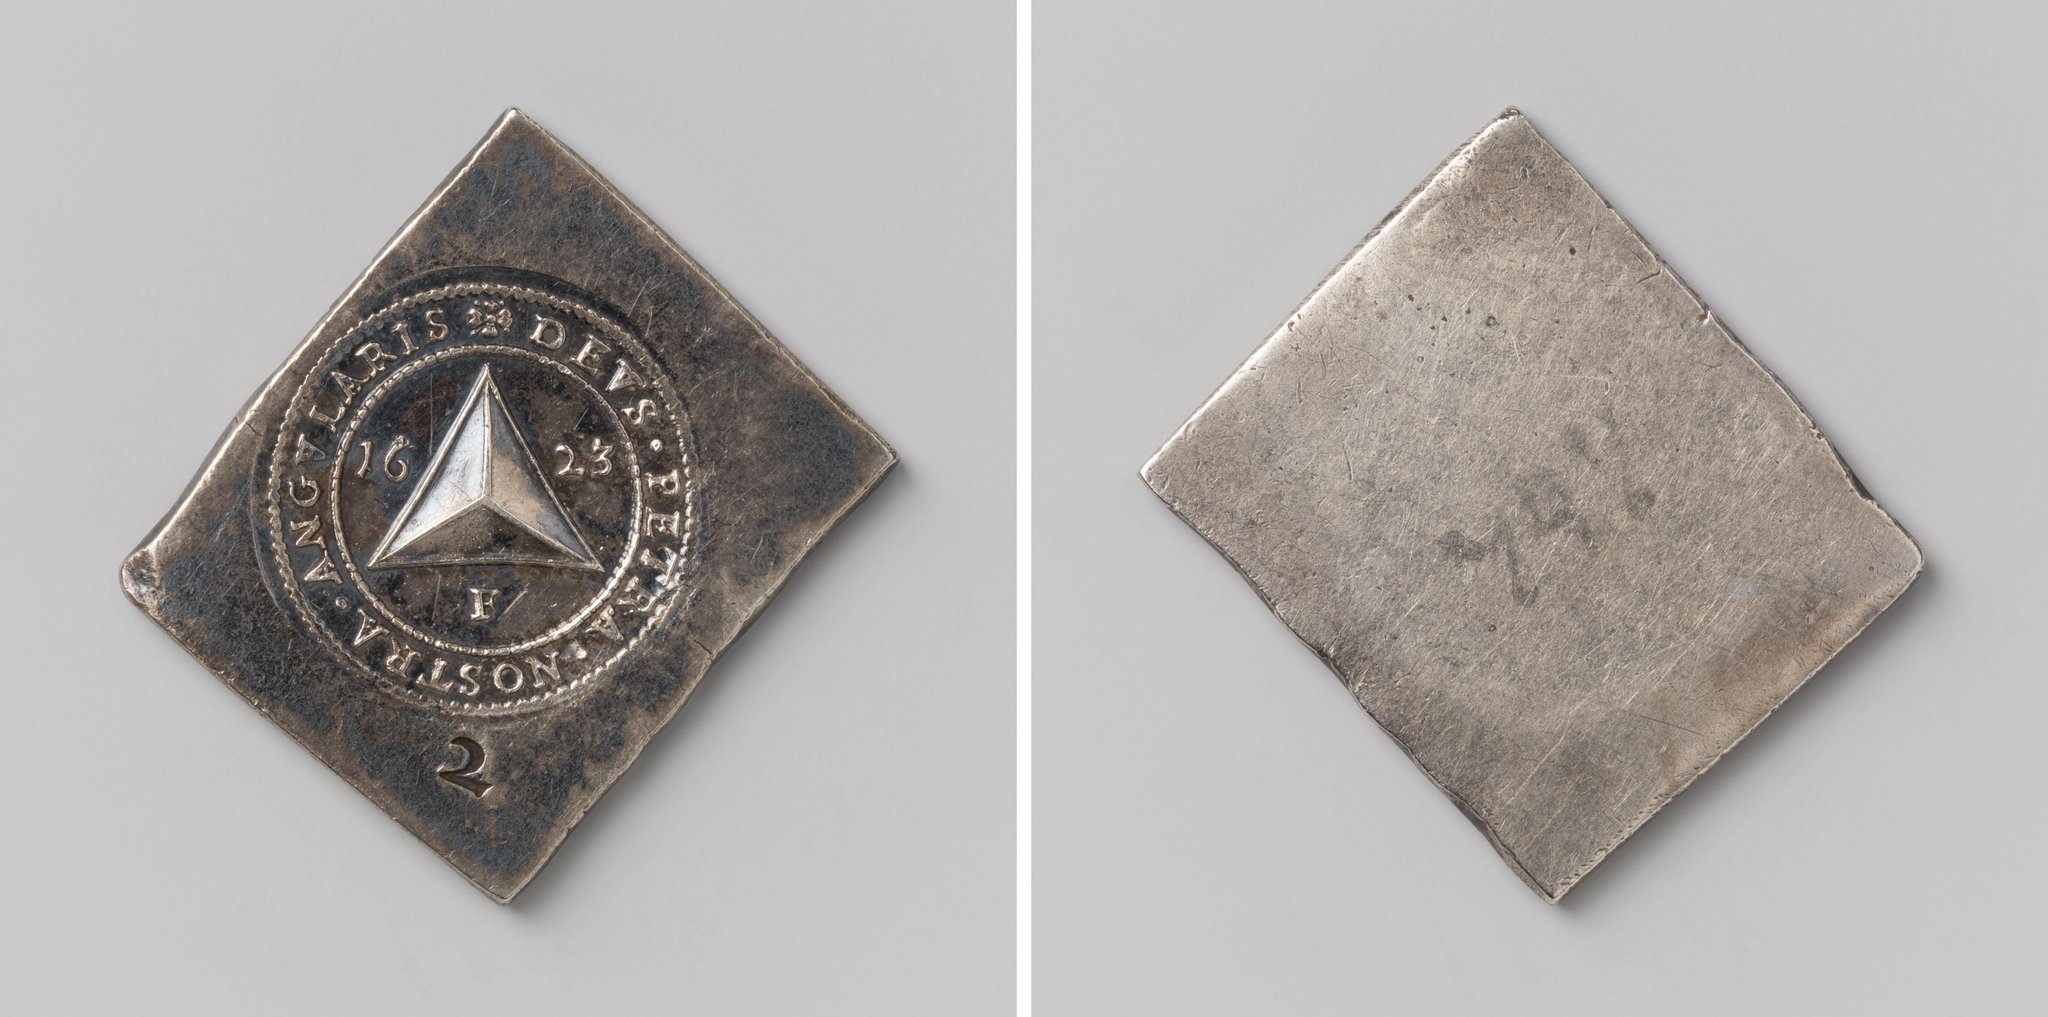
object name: coin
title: halve taler; twee eenheden, noodmunt uit Frankenthal, geslagen tijdens het beleg door Verdugo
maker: Anonymous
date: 1623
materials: silver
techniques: striking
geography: frankenthal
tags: generaal, wilhelm von verdugo (graaf), frankenthal, beleg van frankenthal (1623)